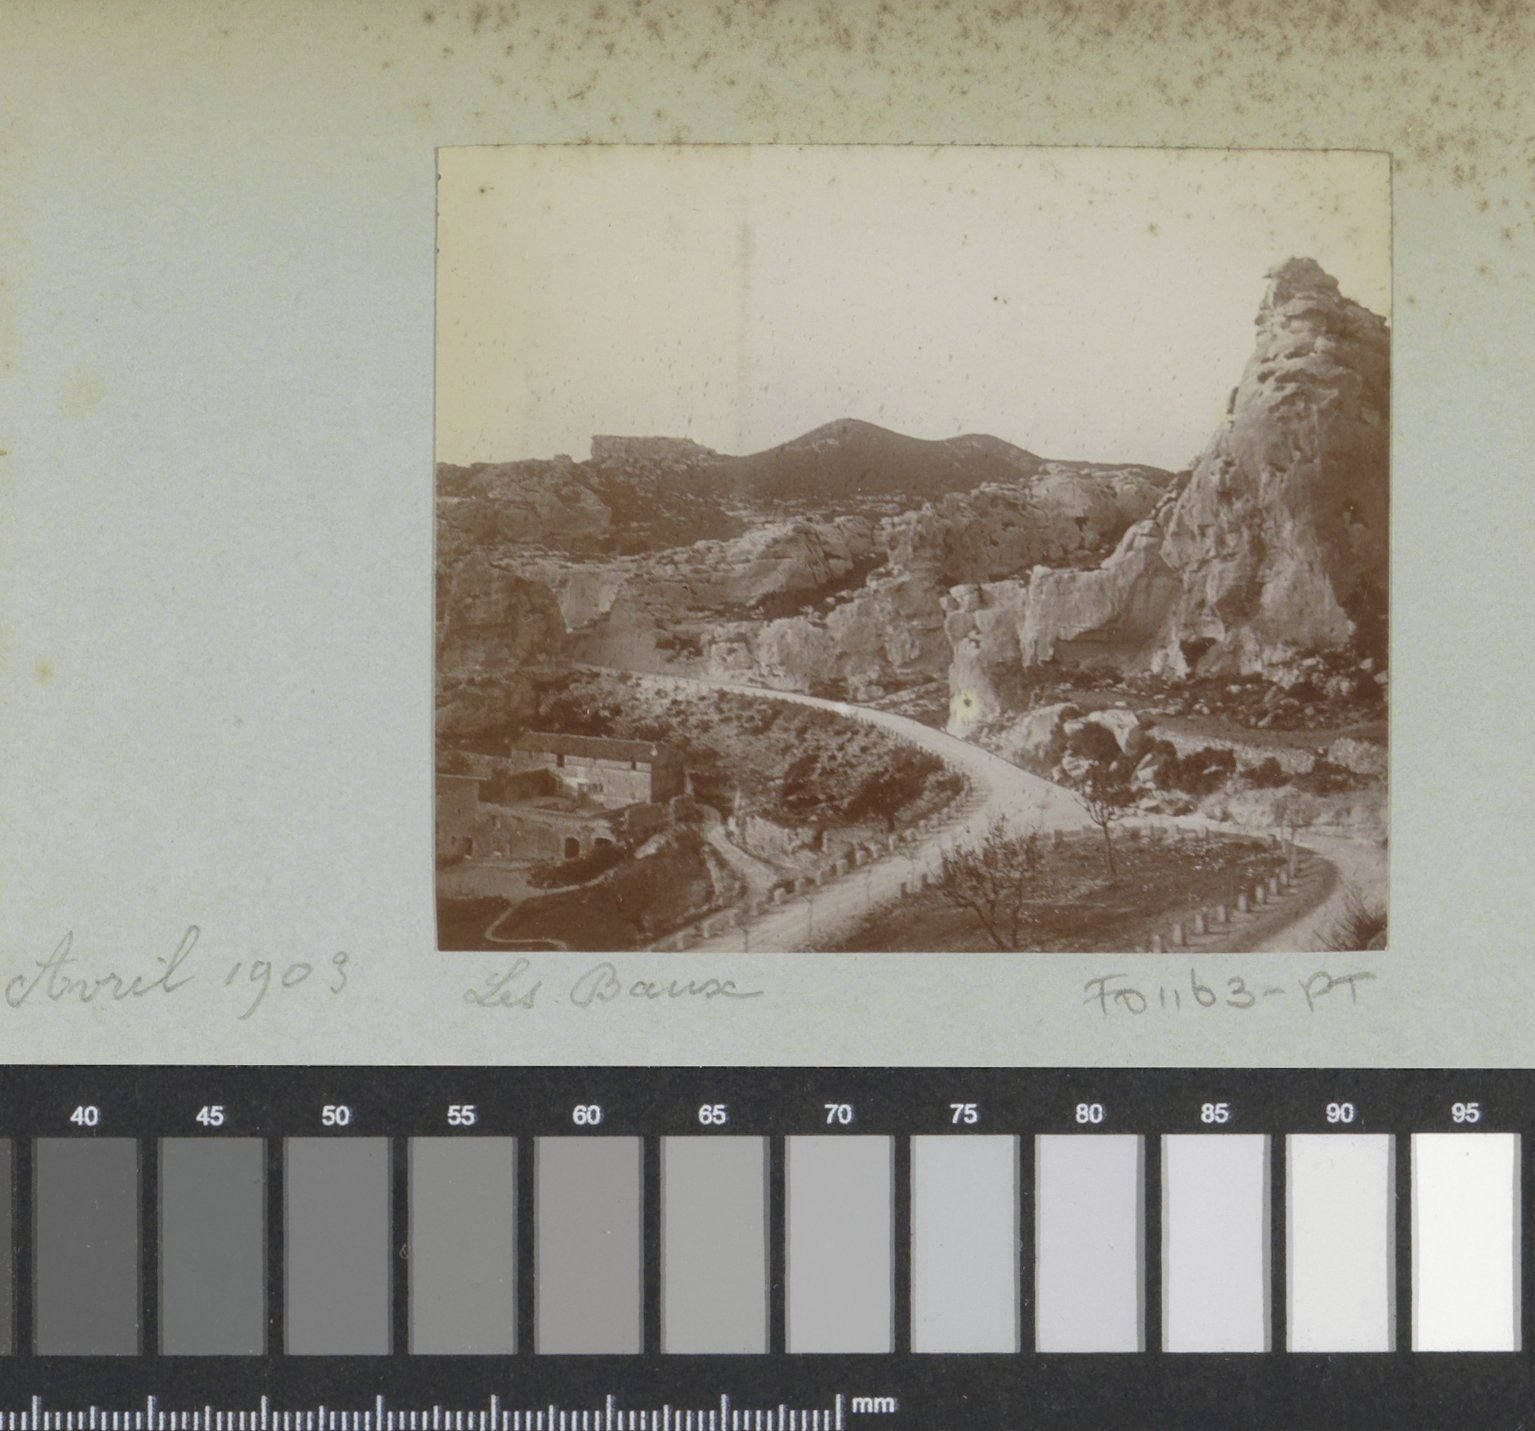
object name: photograph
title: Landschap bij Les Baux-de-Provence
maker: delizy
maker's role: manufacturer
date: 1903-1904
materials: paper, photographic support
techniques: gelatin silver print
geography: les baux-de-provence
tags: road, path, rock-formations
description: Onderdeel van Fotoalbum van een Franse amateurfotograaf met opnames van uitstapjes in Frankrijk, Spanje, België, Luxemburg en Nederland, de eerste automobielen en autoraces.